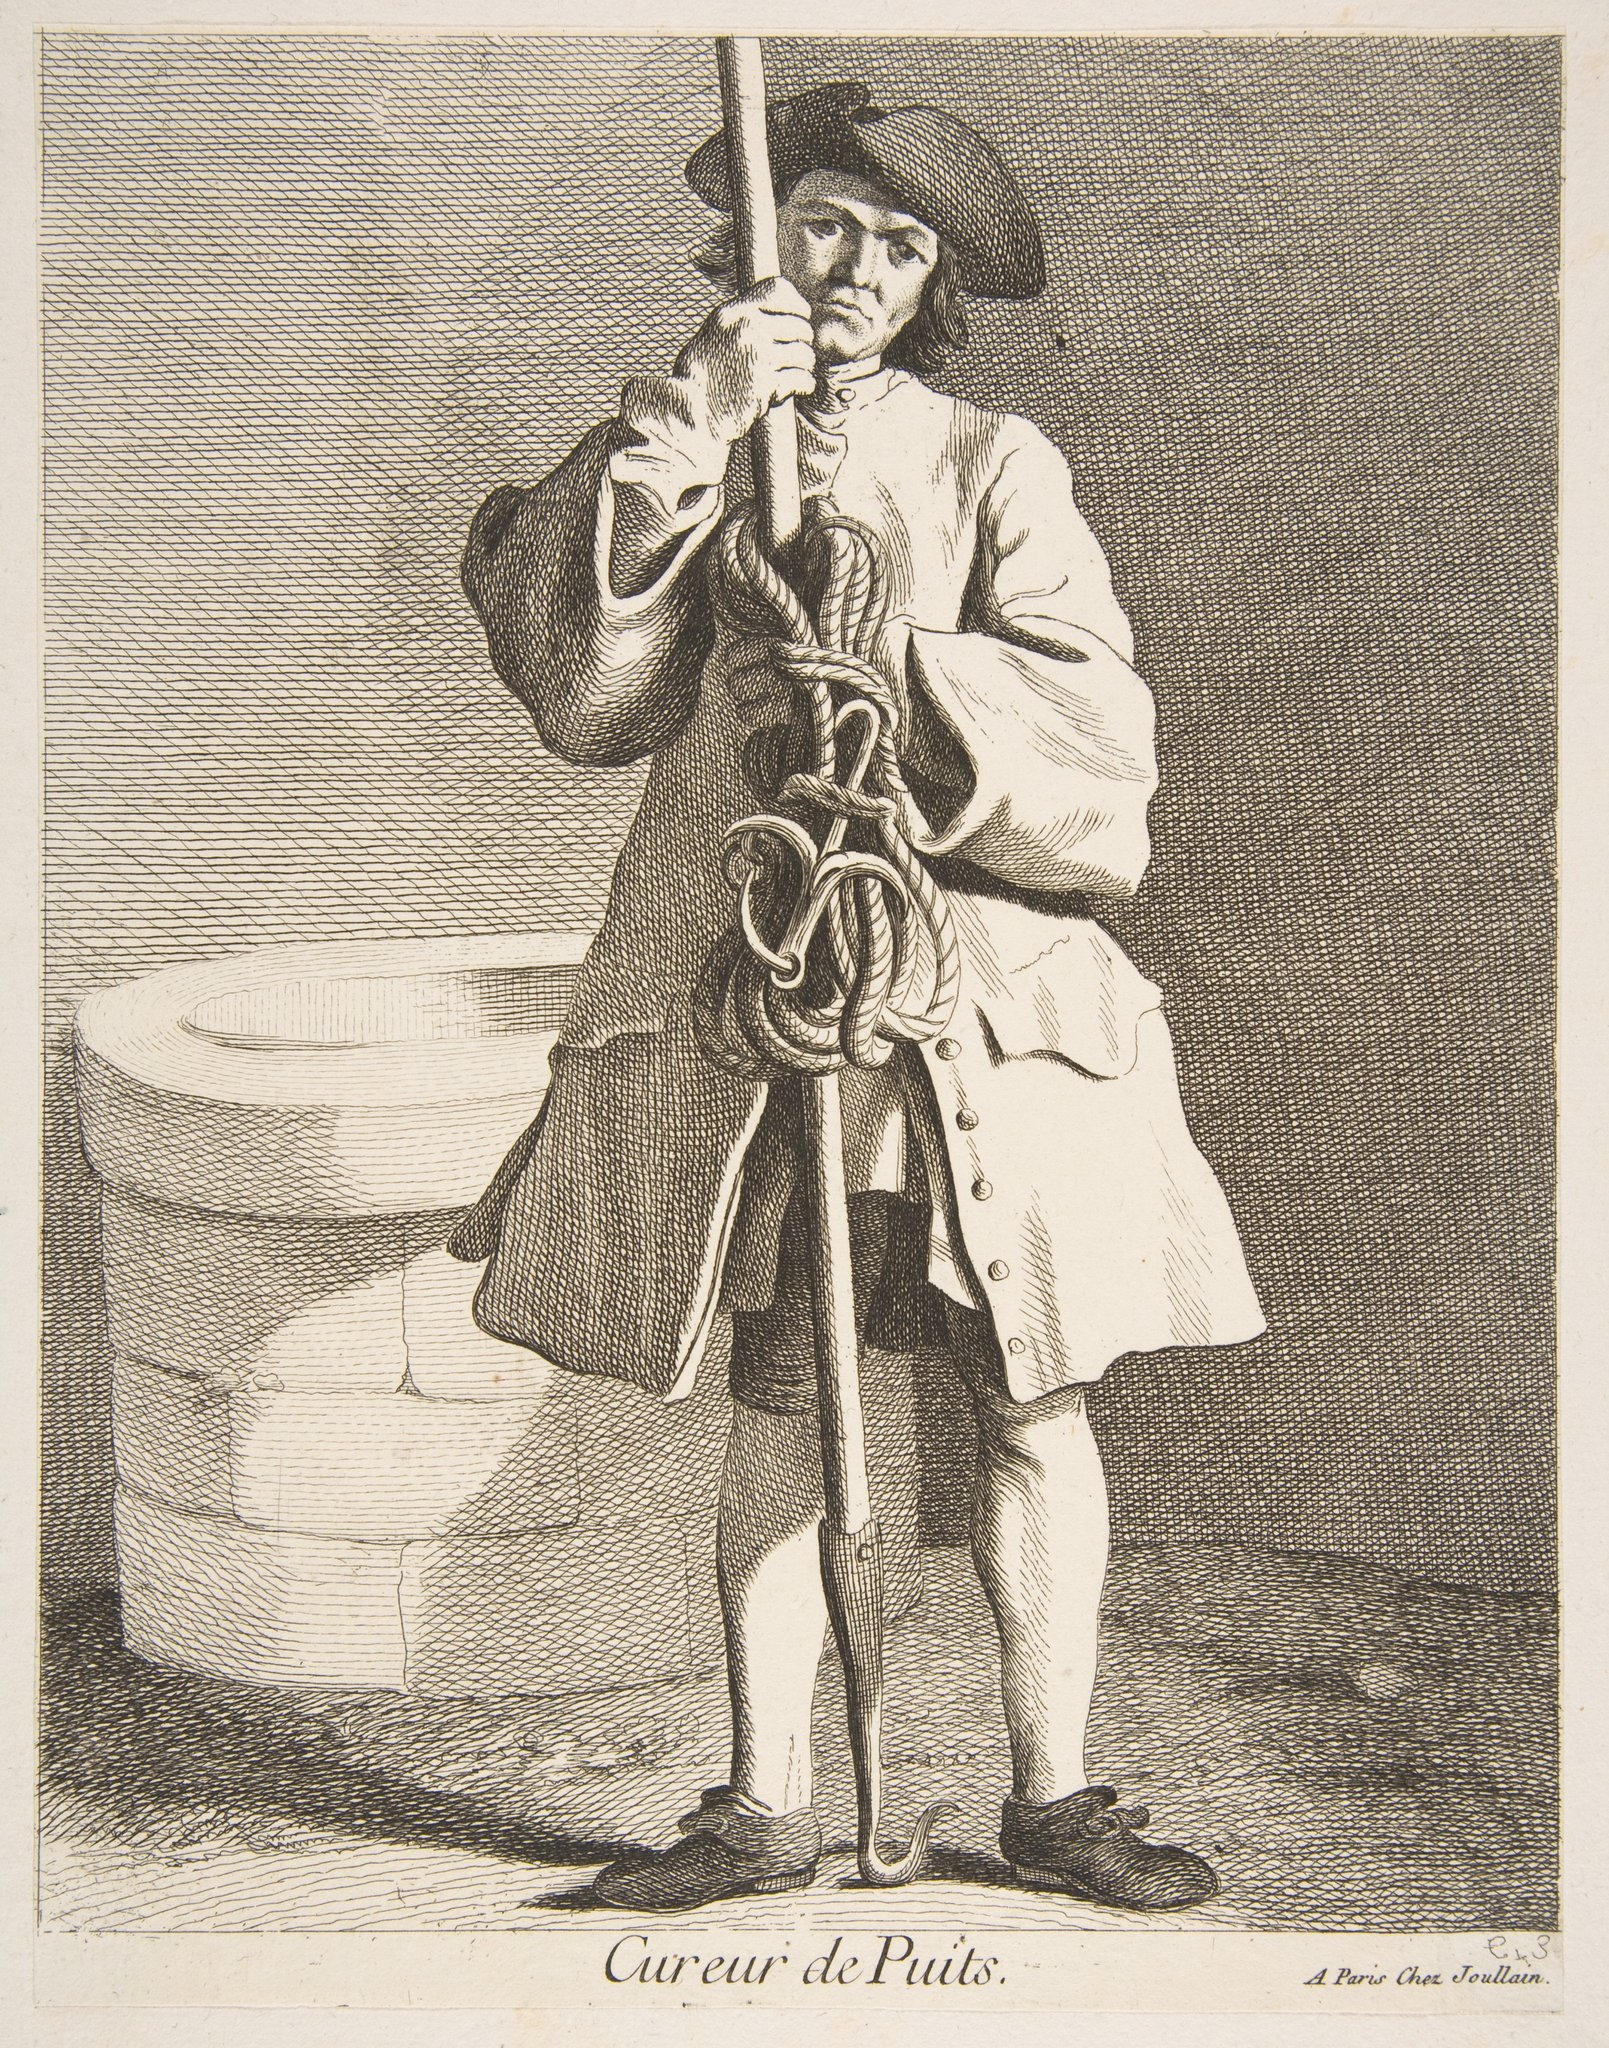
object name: print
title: Well Cleaner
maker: anne claude philippe de tubières, comte de caylus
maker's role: artist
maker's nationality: french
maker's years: 1692-1765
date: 1746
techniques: engraving, etching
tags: wells,men